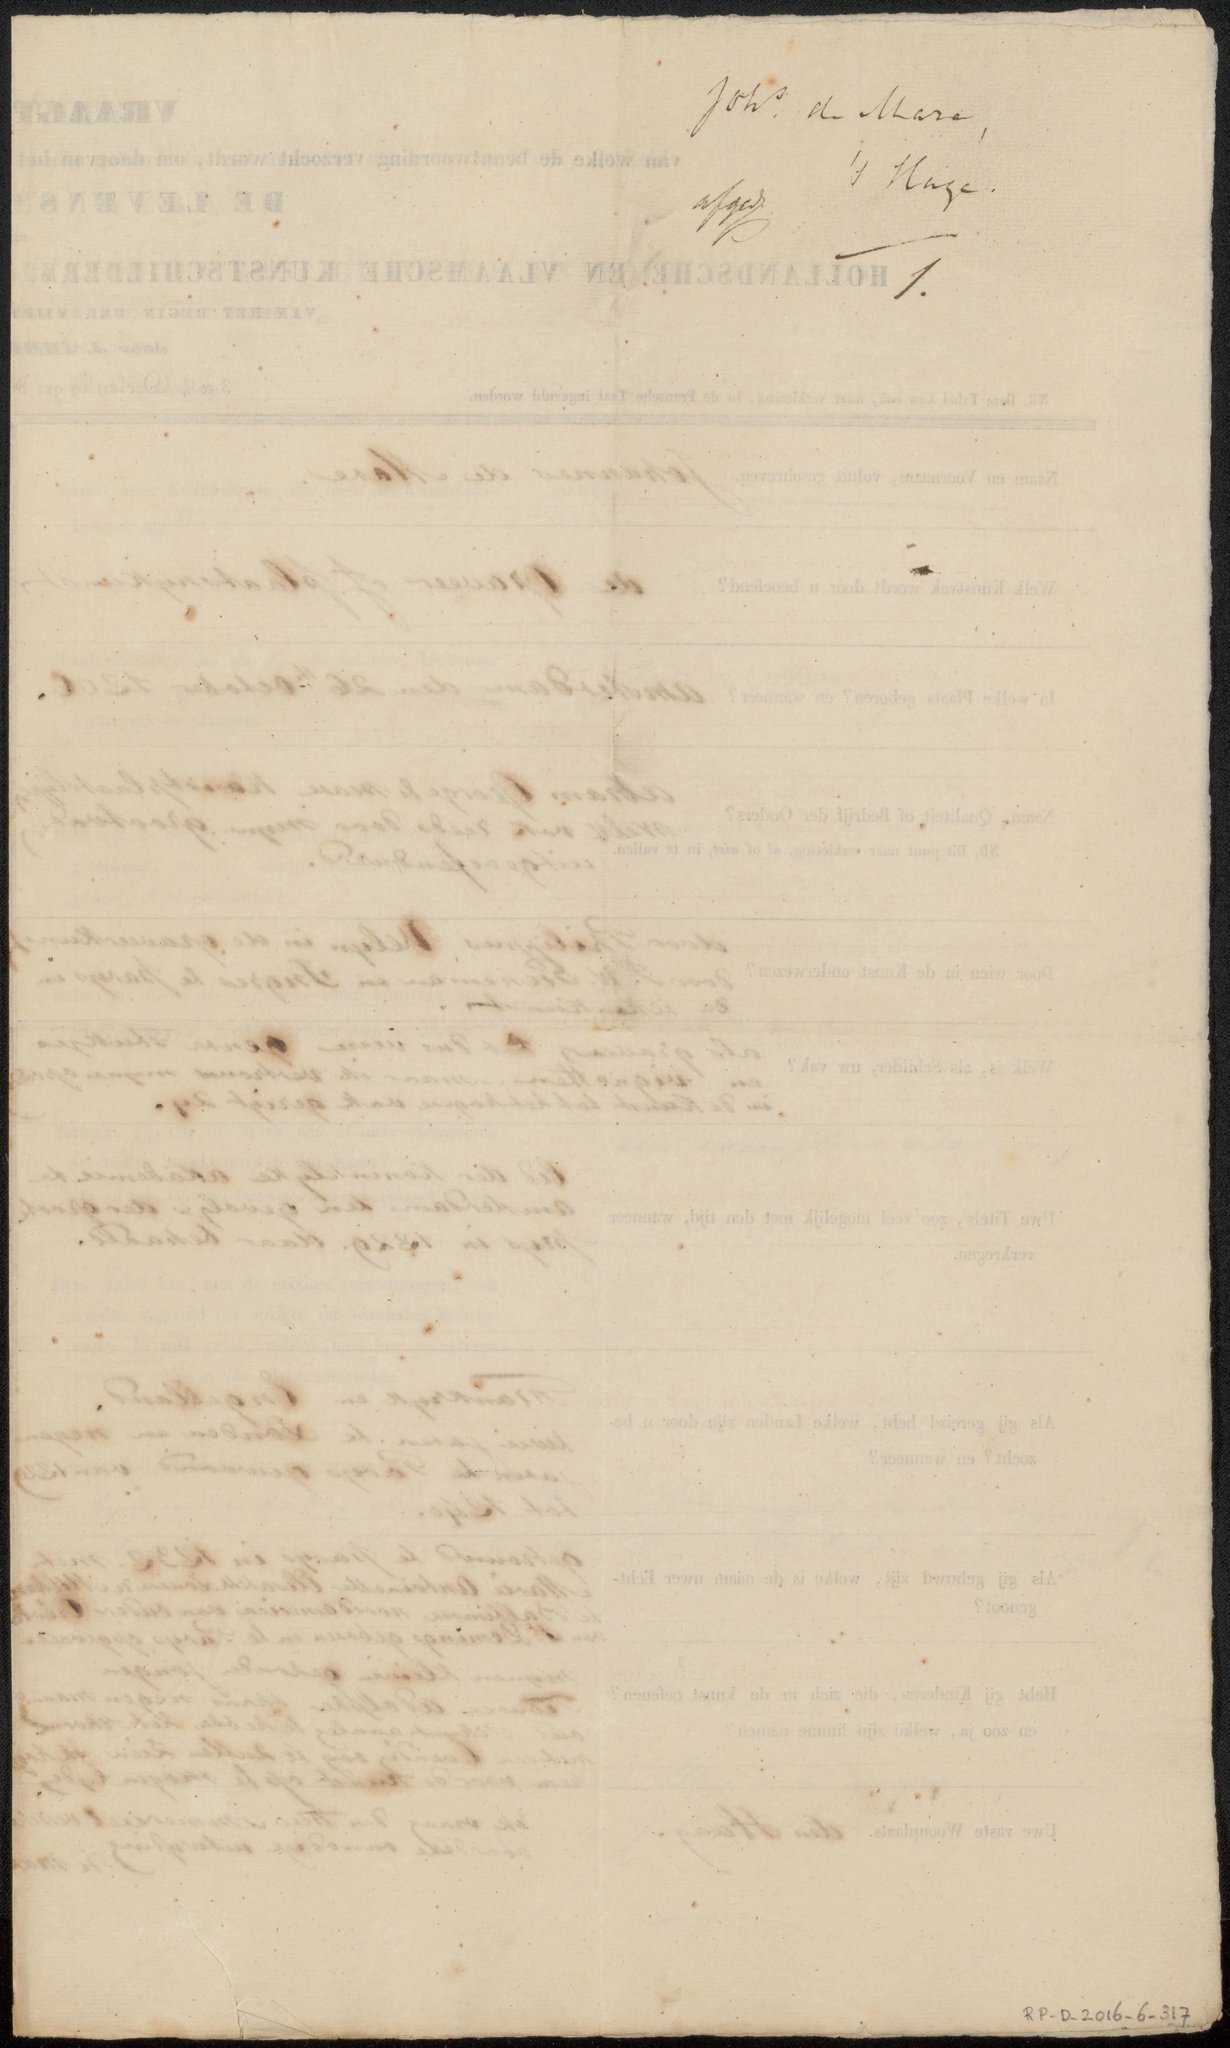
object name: manuscript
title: Enquêteformulier ingevuld door Johannes de Mare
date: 1841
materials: ink, paper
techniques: pen, printing, writing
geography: the hague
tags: print maker, johannes de mare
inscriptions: inscription: ‘Vraagpunten,/ van welke de beantwoording verzocht wordt, om daarvan het noodig gebruik te maken in het uit te geven Werk, getiteld: De levens en werken/ der Hollandsche en Vlaamsche kunstschilders, beeldhouwers,/ graveurs en bouwmeesters, van het begin der vijftiende eeuw tot heden/ door J. Immerzeel, Jr.’, watermark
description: Opgenomen in: Immerzeel, J. Jr., De levens en werken der Hollandsche en Vlaamsche kunstschilders, beeldhouwers, graveurs en bouwmeesters, van het begin der vijftiende eeuw tot heden, Amsterdam: J.C. van Kesteren, 1842-1843.